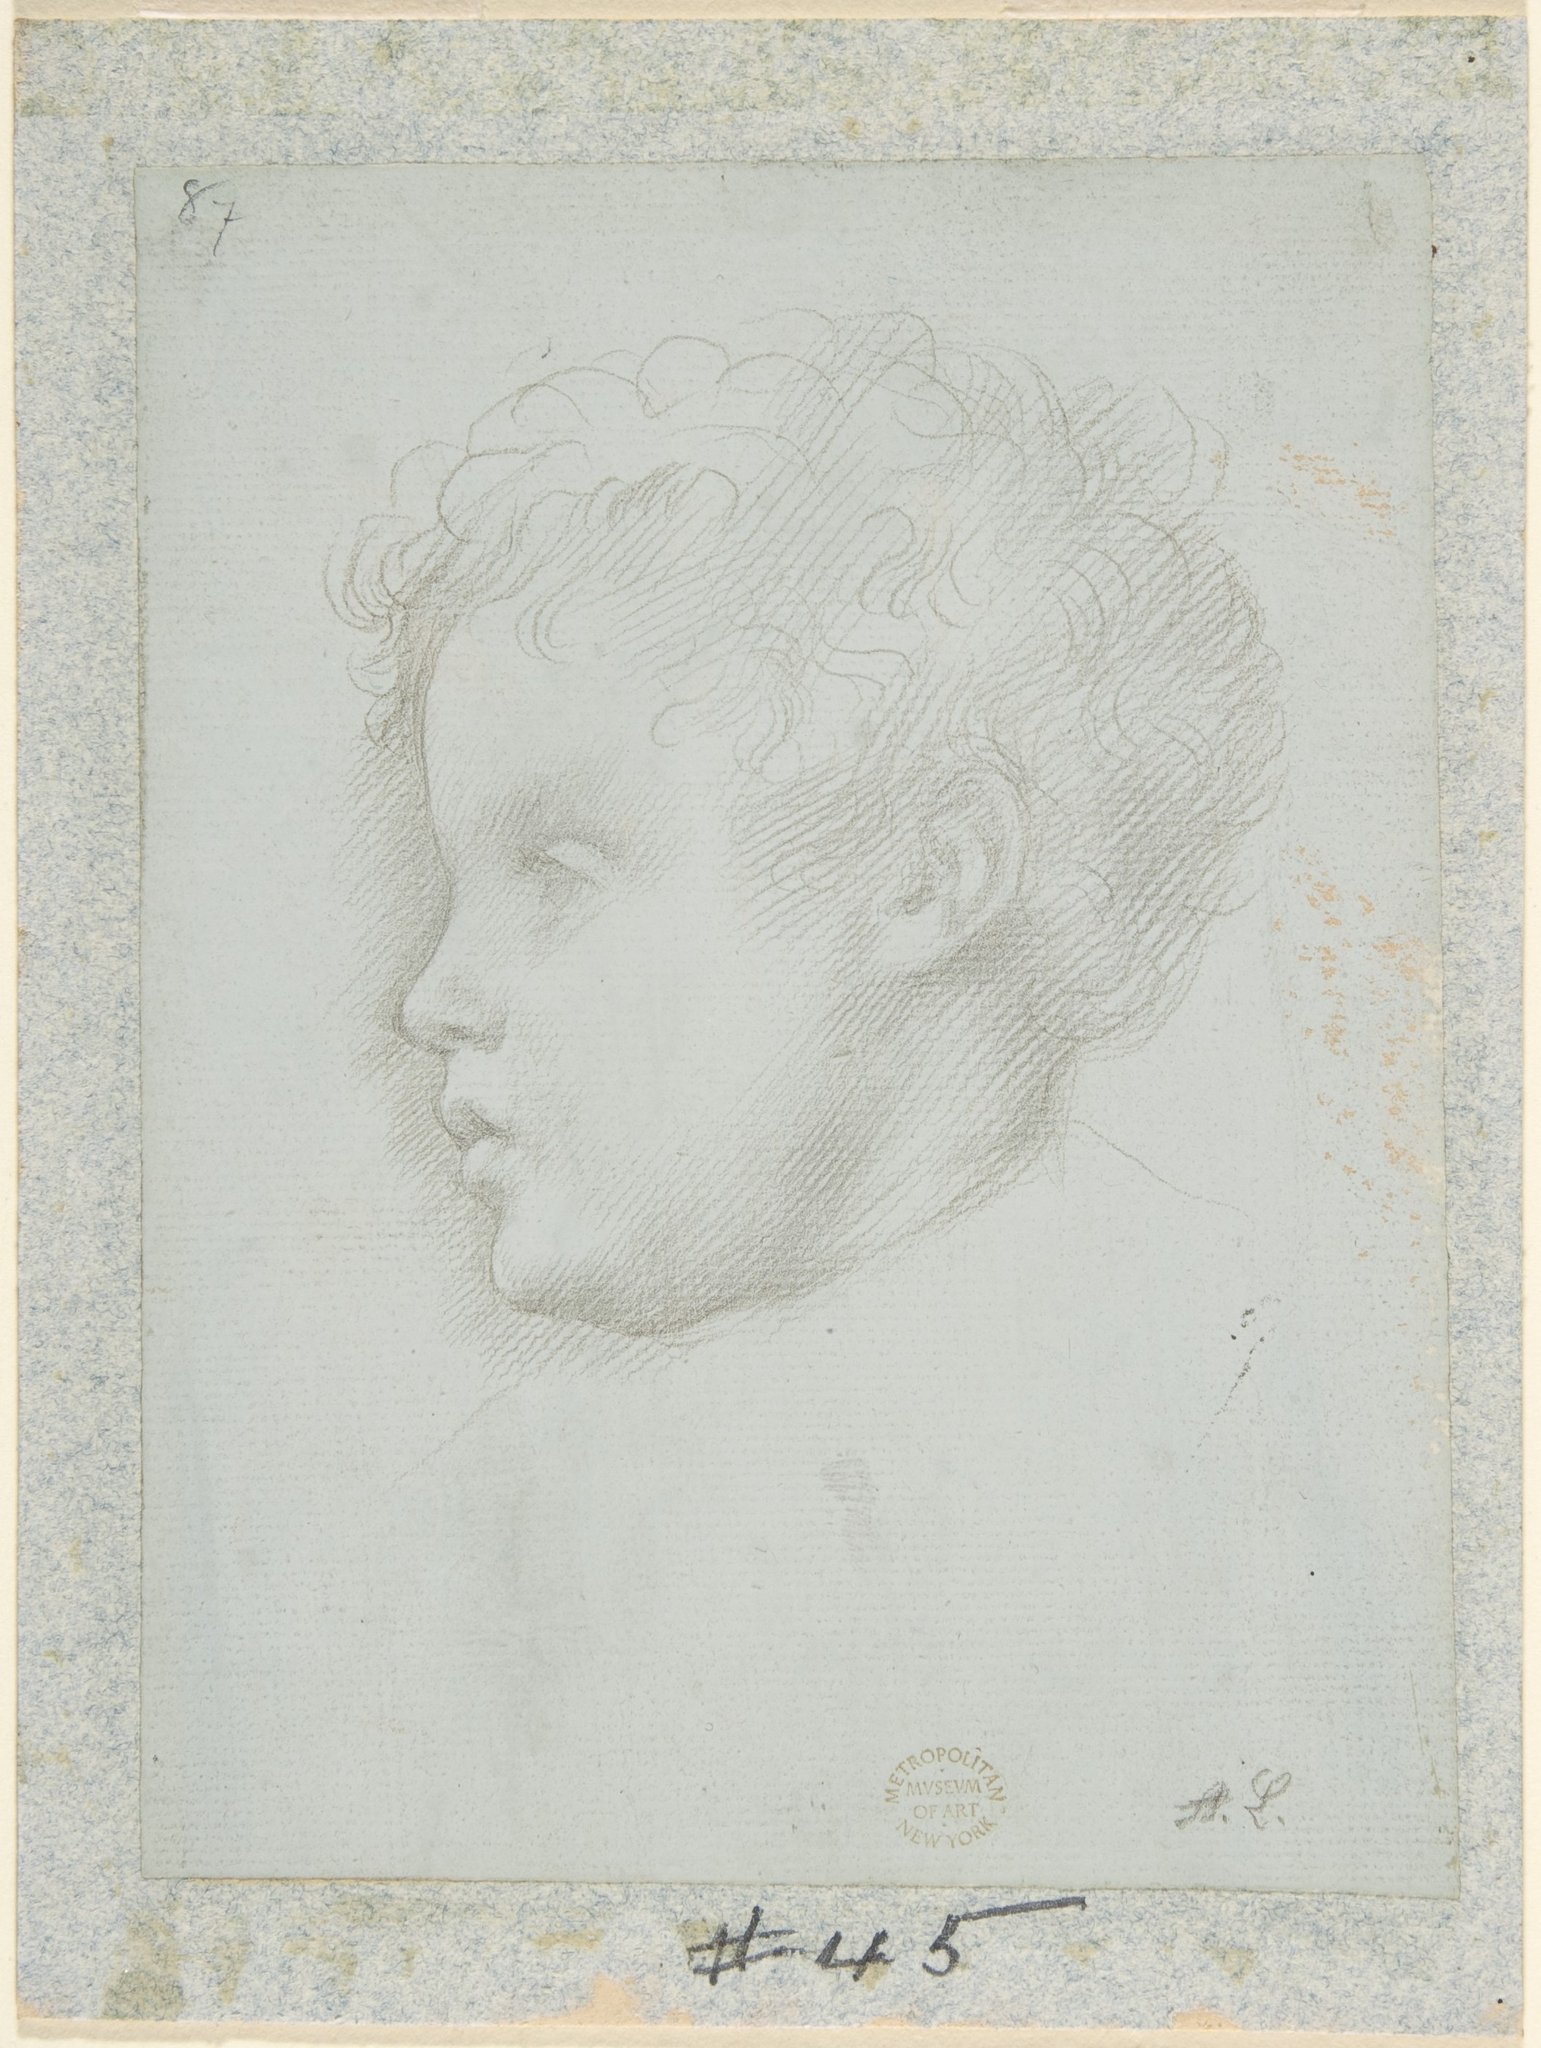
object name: drawing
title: Study of a Head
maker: alphonse legros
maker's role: artist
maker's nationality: french and british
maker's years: 1837-1911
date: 1837-1911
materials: graphite, paper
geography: france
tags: heads,boys,profiles